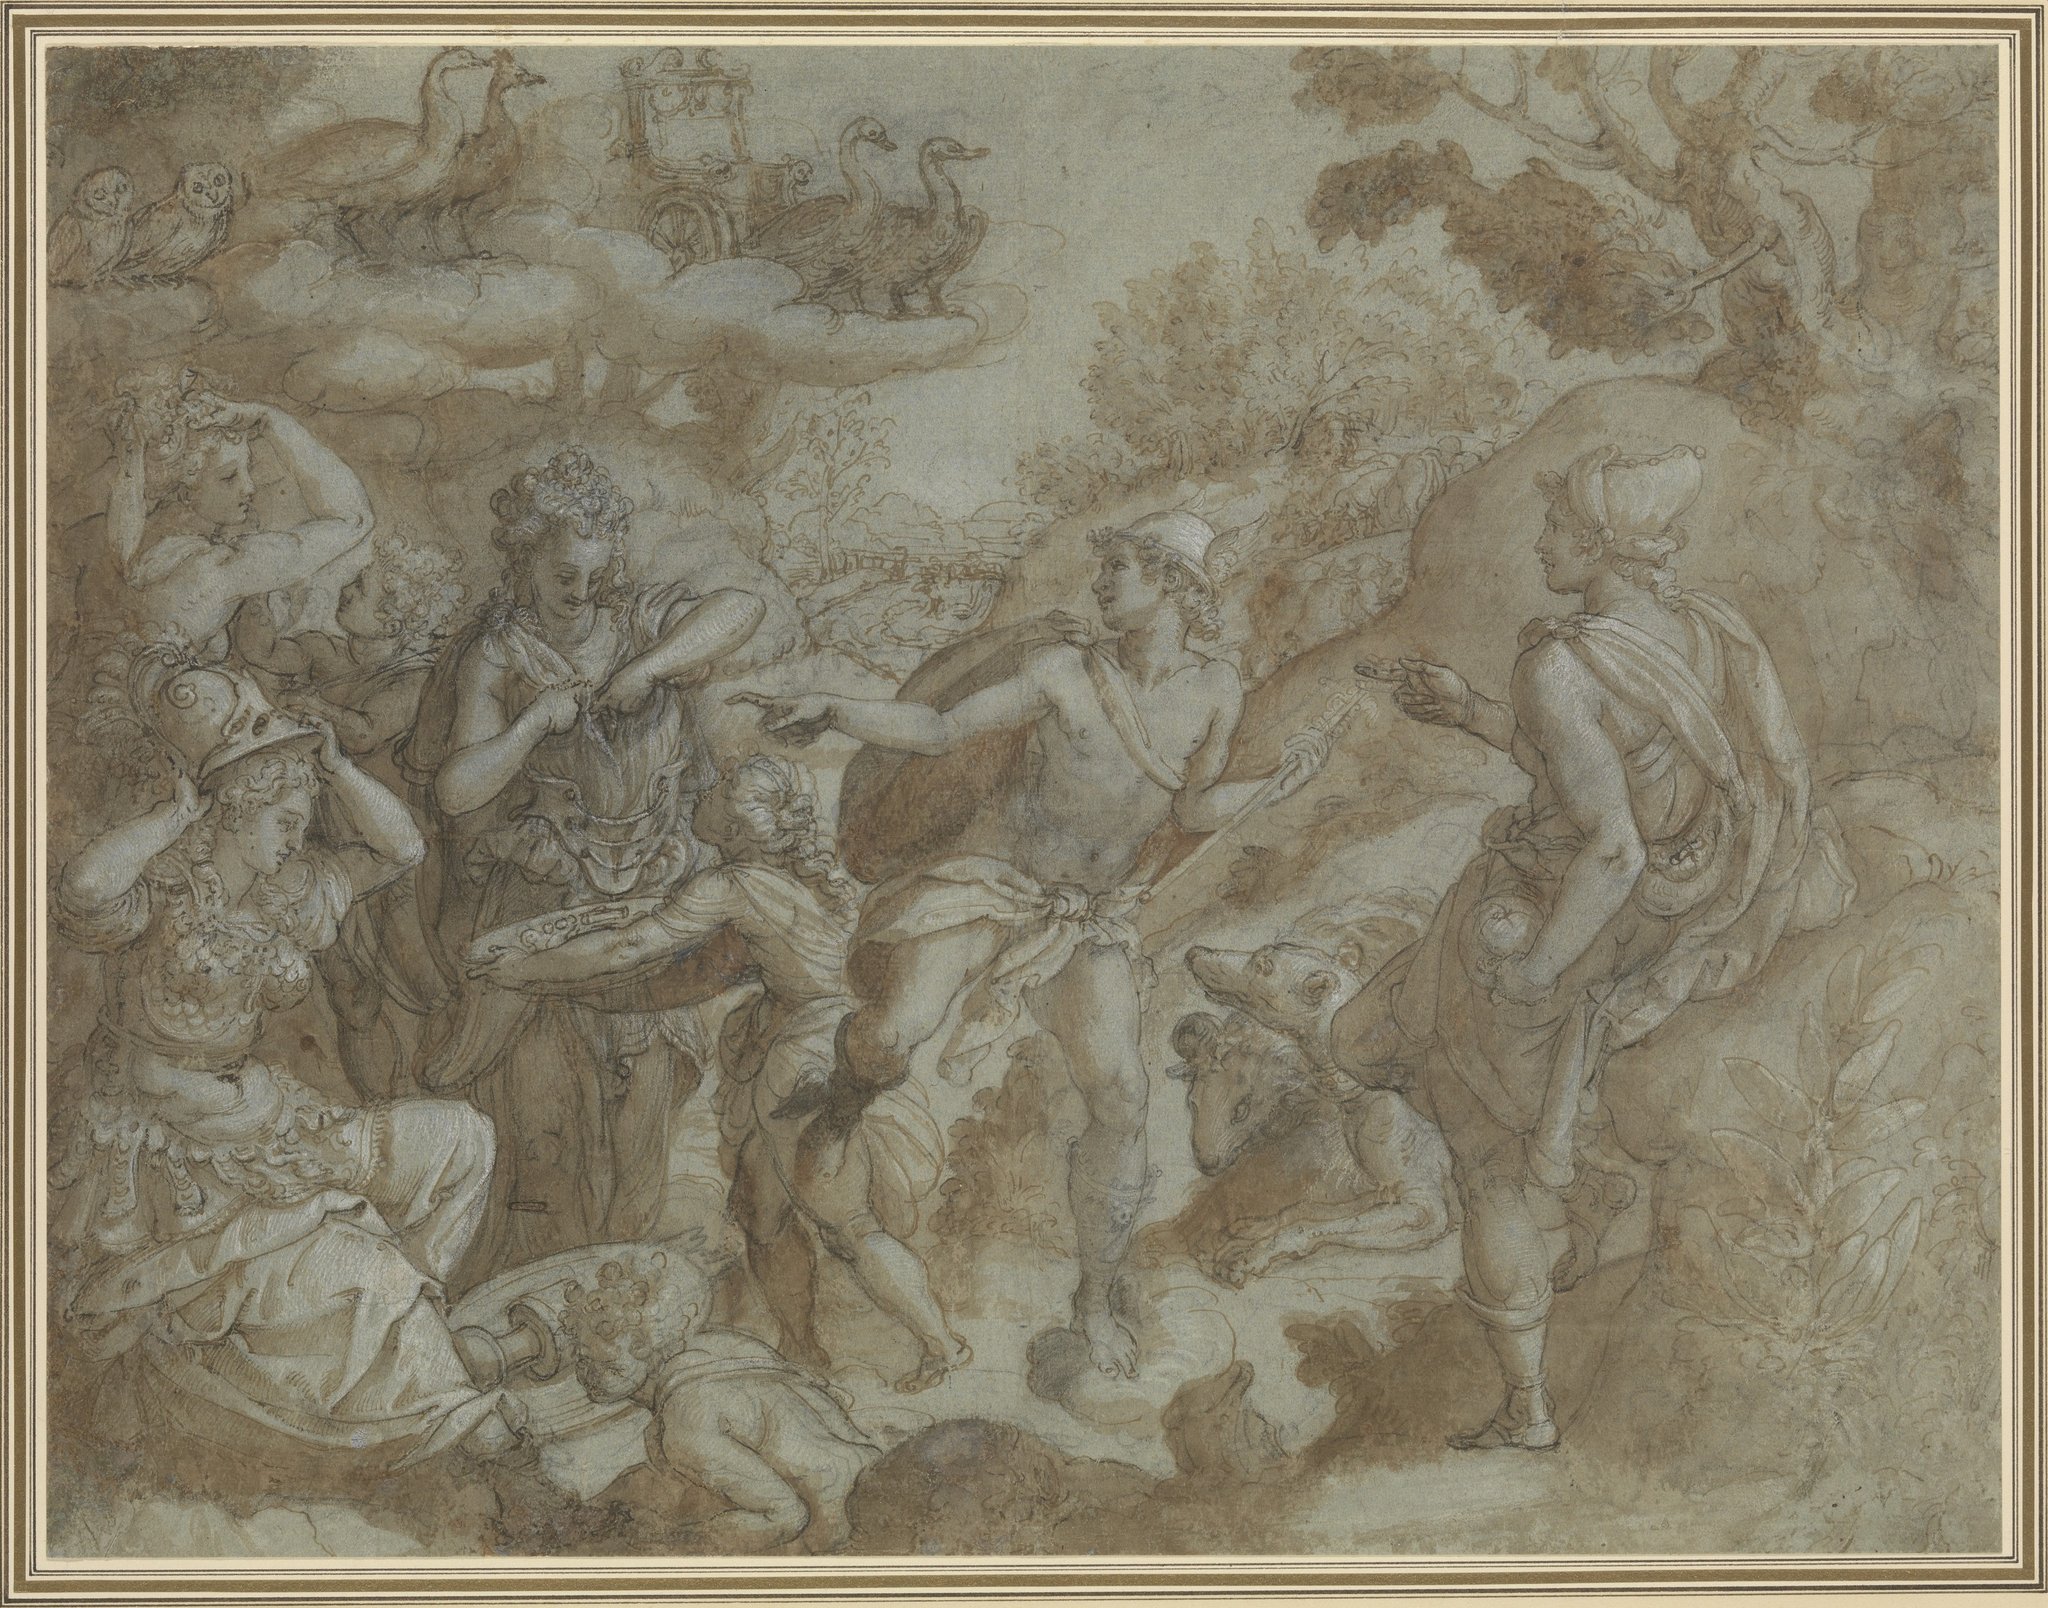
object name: drawing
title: The Judgment of Paris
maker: alessandro allori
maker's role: artist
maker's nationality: italian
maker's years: 1535-1607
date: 1583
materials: chalk, gouache, ink, paper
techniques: brush, highlighting, pen, wash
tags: men,women,owls,peacocks,swans